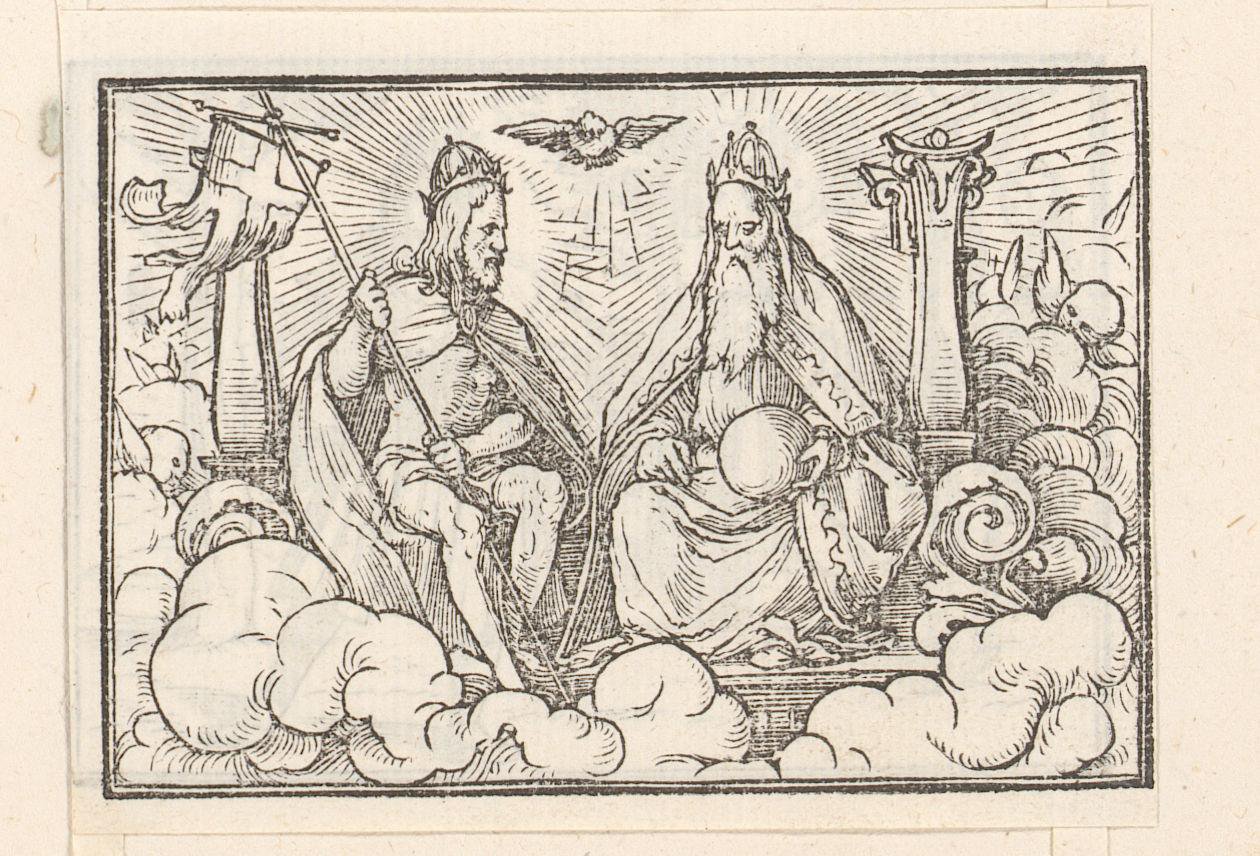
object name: print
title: Geschiedenis van het Oude Testament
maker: veit rudolf specklin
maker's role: print maker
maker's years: -1550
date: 1538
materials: paper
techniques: woodcut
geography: switzerland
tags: the holy trinity, 'trinitas coelestis'; father, son and holy ghost ~ christian religion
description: Boekillustratie voor het eerst gebruikt in: Biblia Utriusque Testamenti iuxta Vulgatam Translationem, Lyon, M. en G. Trechsel (voor Hugo à Porta) 1538. Later in verschillende uitgaven opnieuw gebruikt. Deze prent vermoedelijk gebruikt in één van de uitgaven uitgegeven en/of gedrukt door Jean Frellon, Lyon.